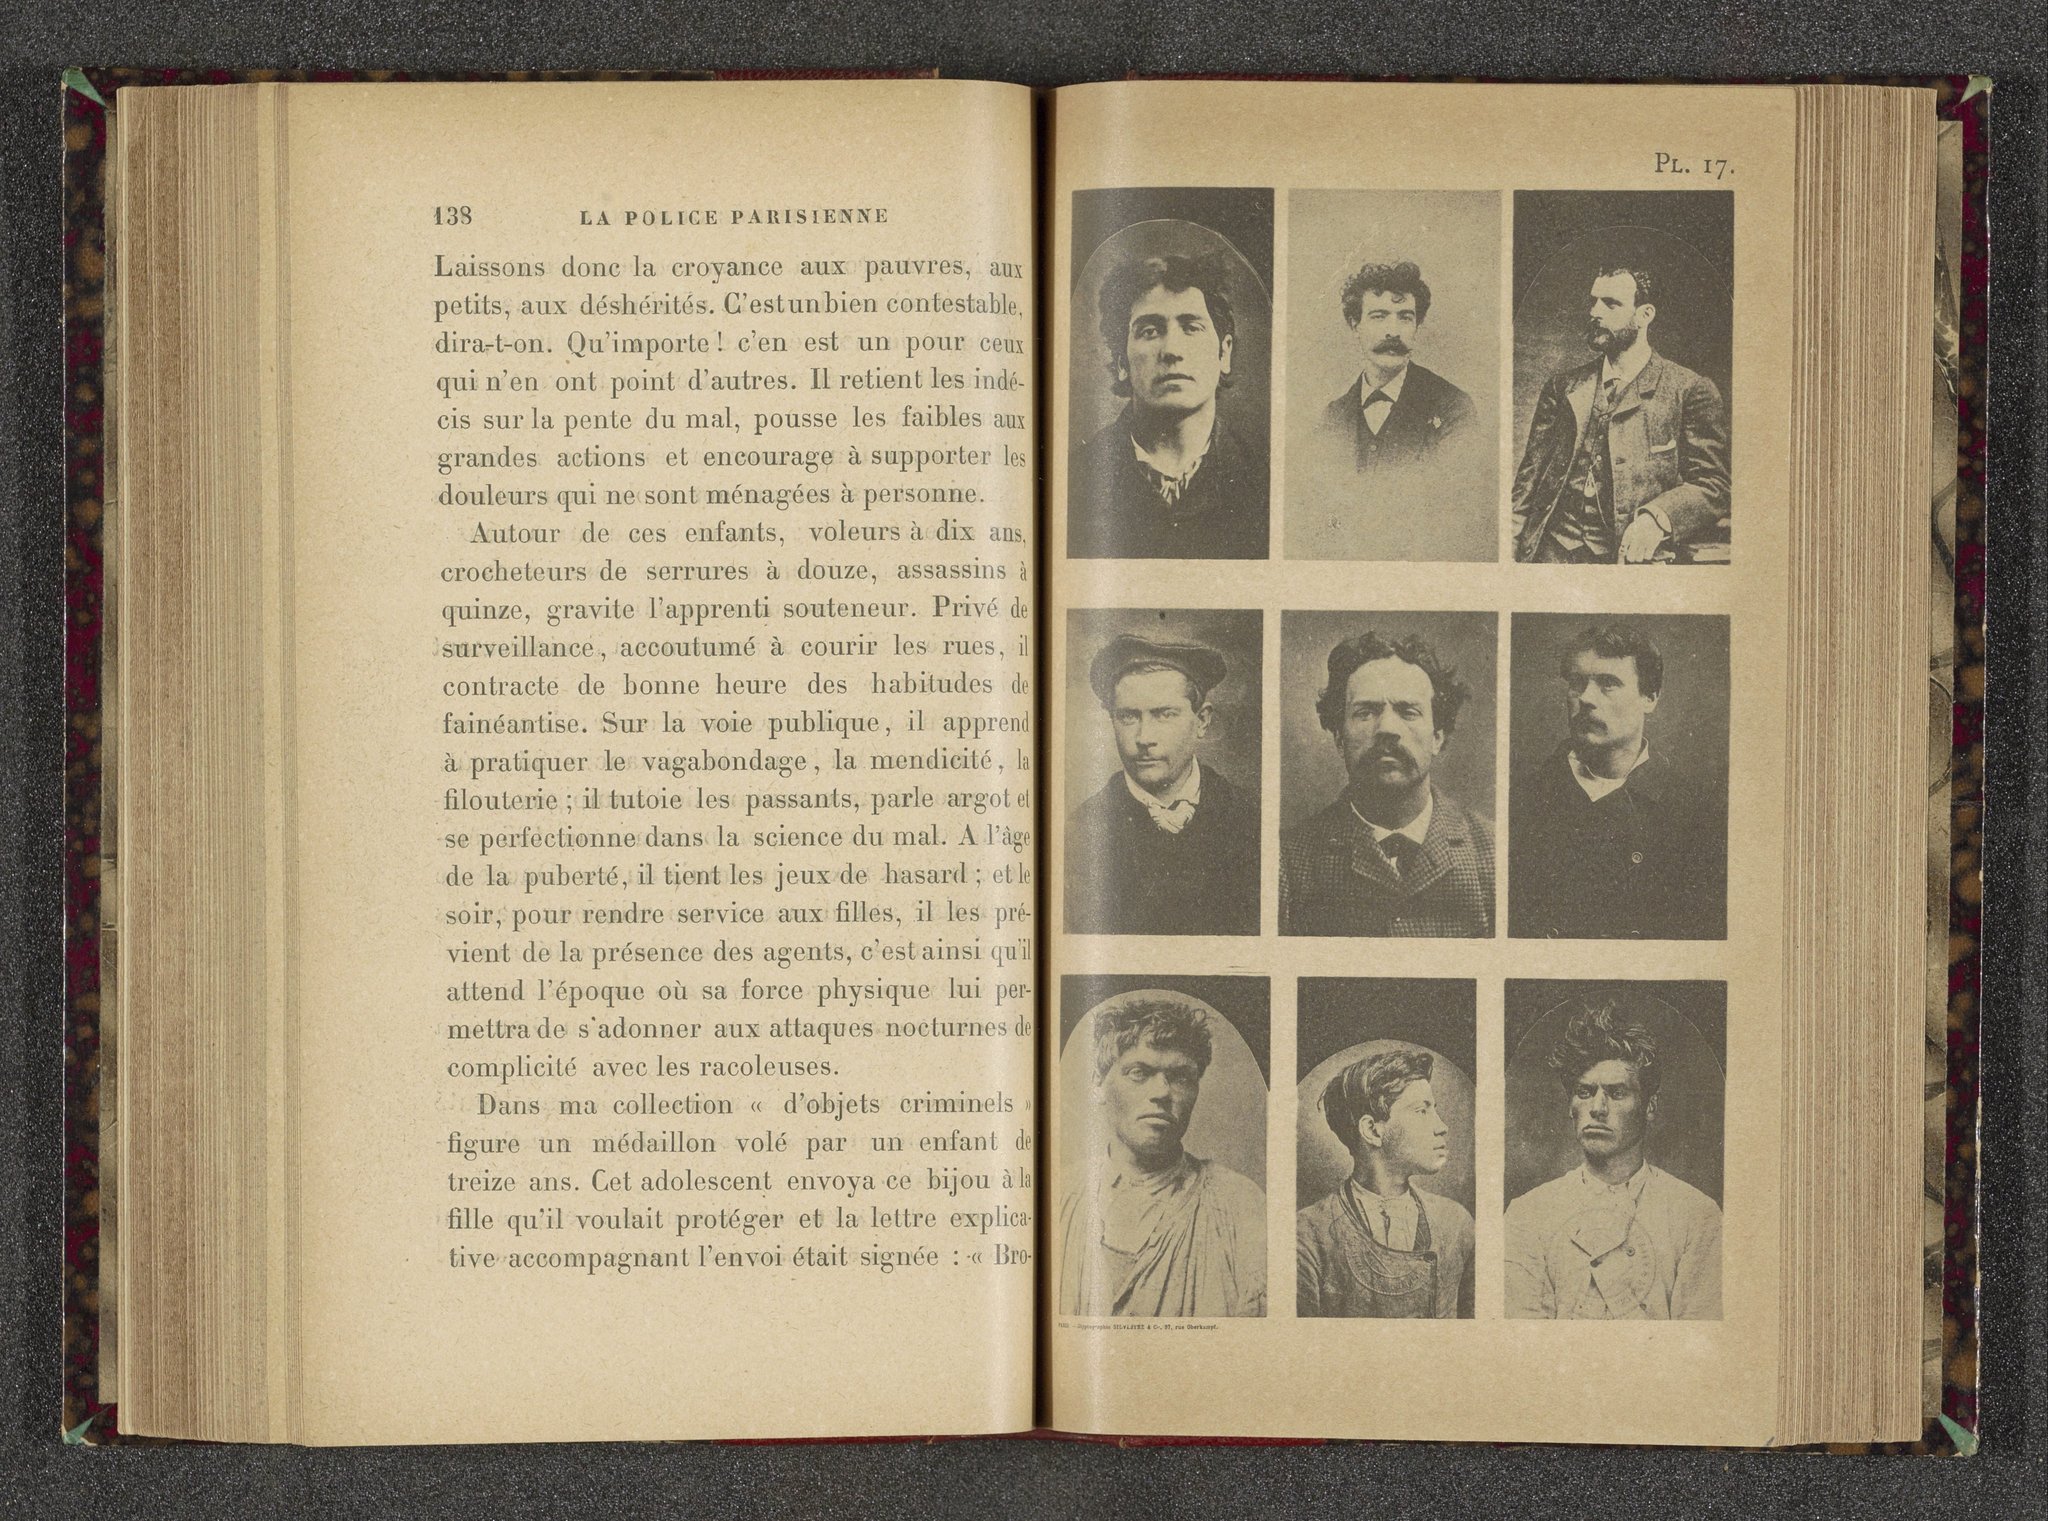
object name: page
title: Negen portretten van onbekende pooiers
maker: Anonymous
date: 1880-1890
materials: paper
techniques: photograph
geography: paris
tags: pimp (brothel scene)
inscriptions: number: ‘Pl. 17.’